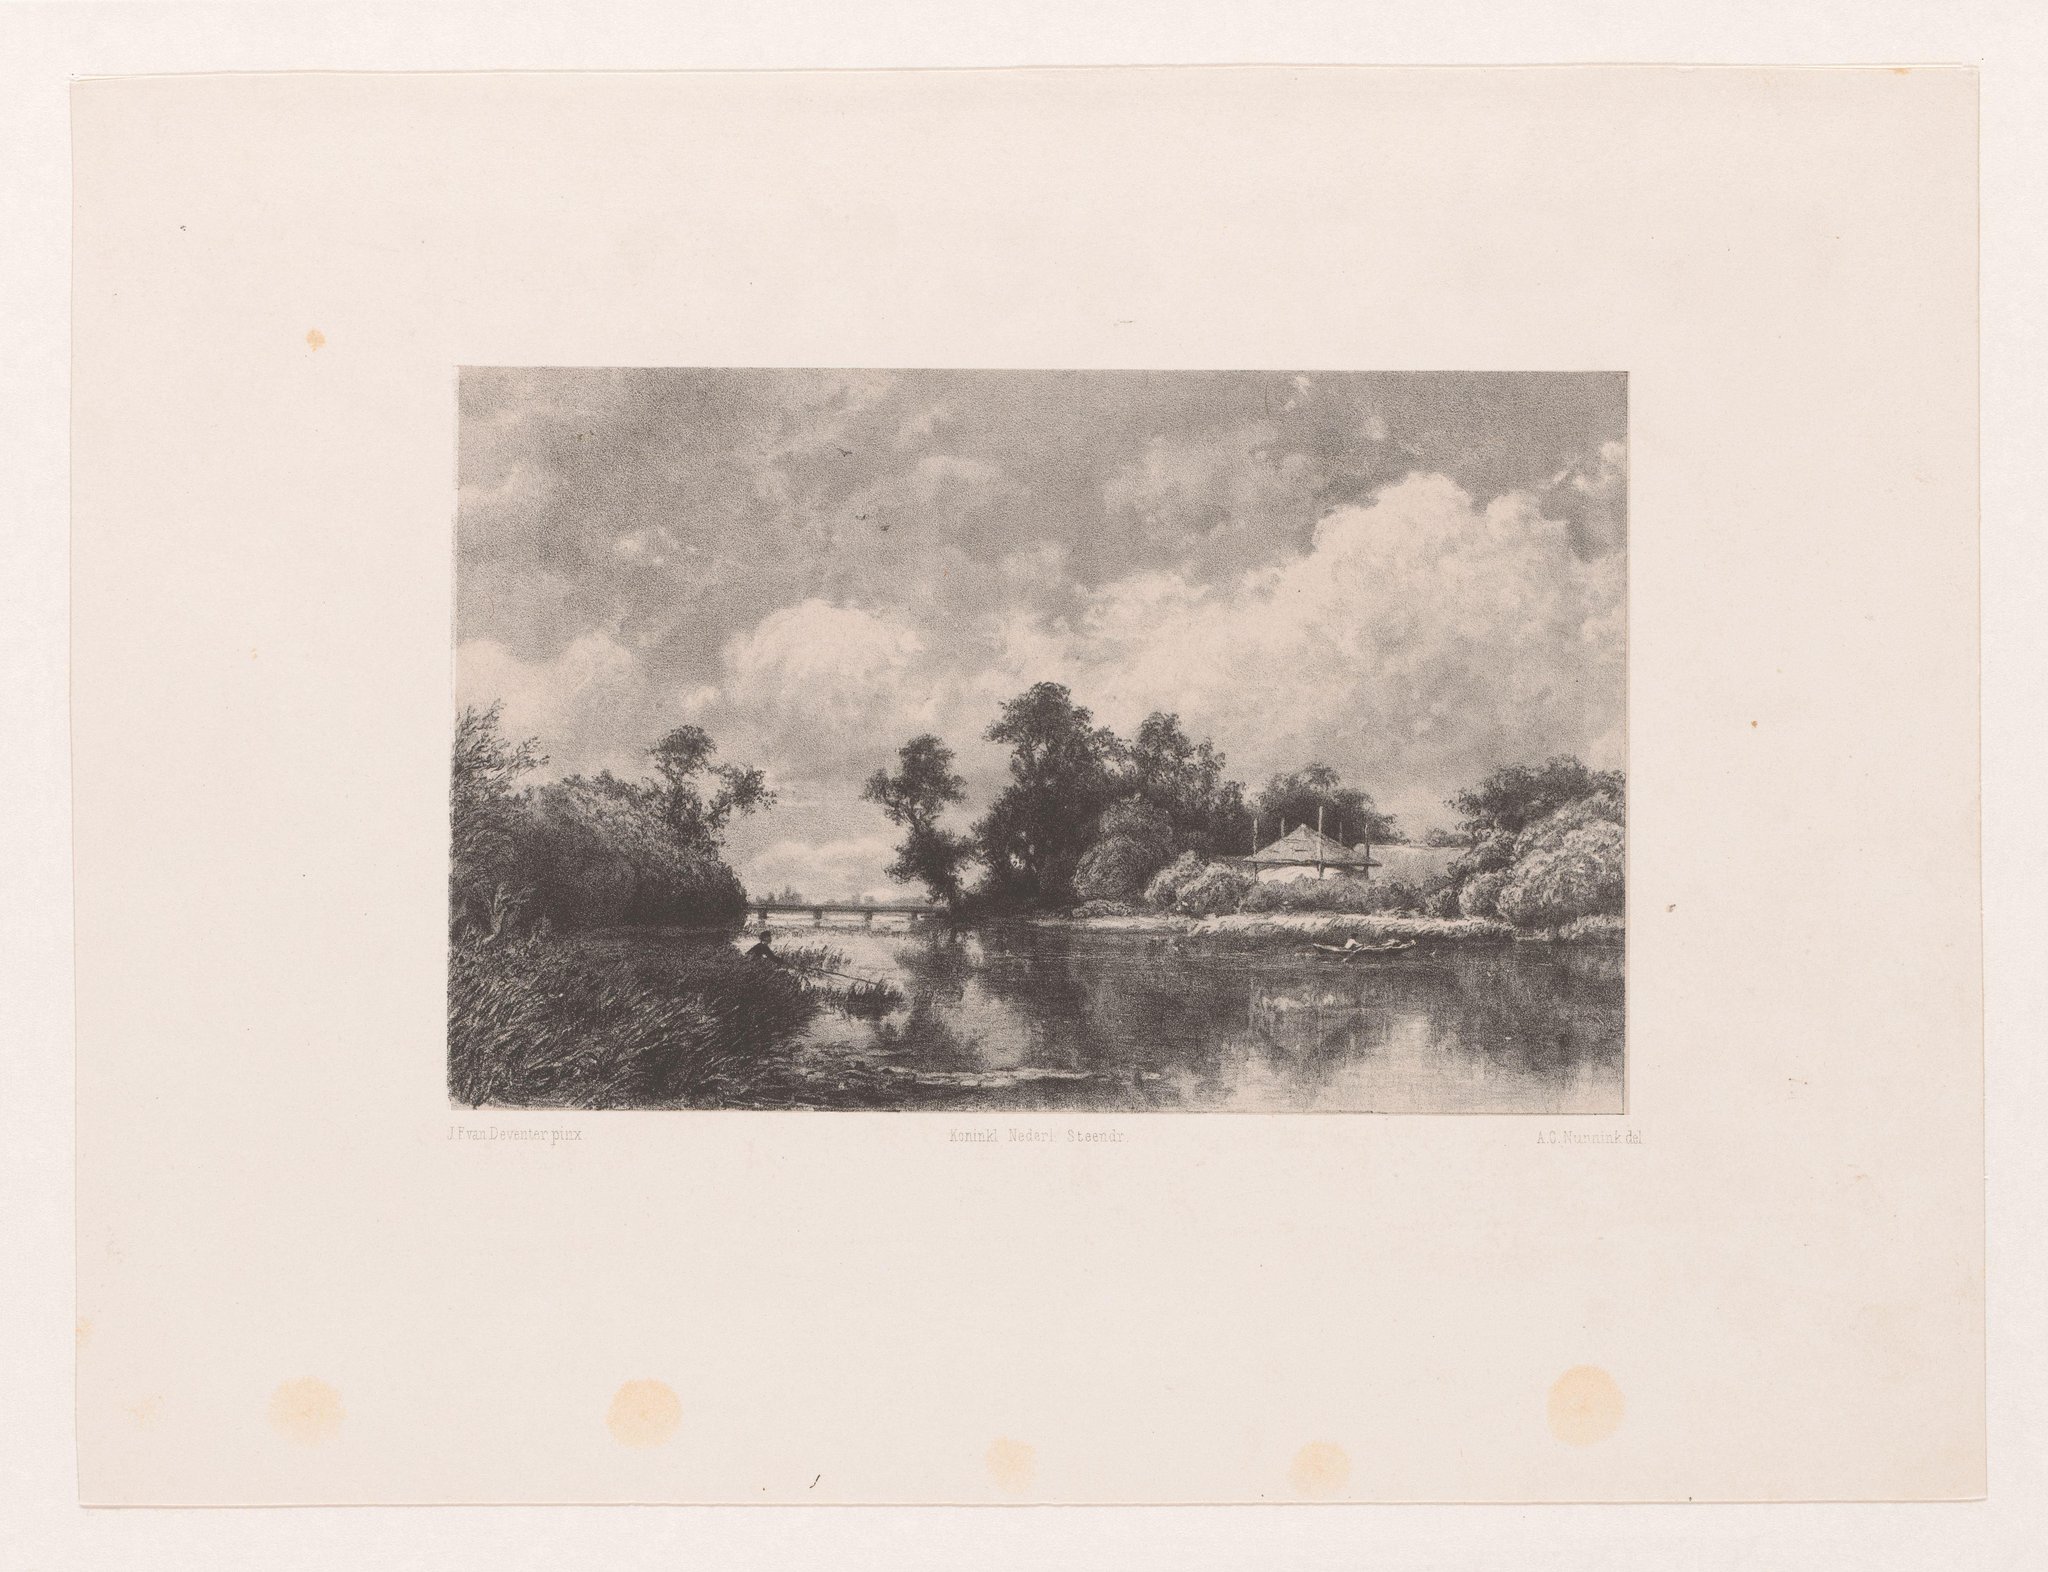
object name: print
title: Landschap met visser en roeiboot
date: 1867-1874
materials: paper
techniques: lithograph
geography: the hague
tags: fishing (sports), landscapes (+ landscape with figures, staffage), boat propelled by man or animal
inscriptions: collector's mark: Lugt 2228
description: Langs de oever van een rivier zit een man met een hengel. Op de rivier vaart een figuur in een roeiboot. Aan de overzijde een afdak.